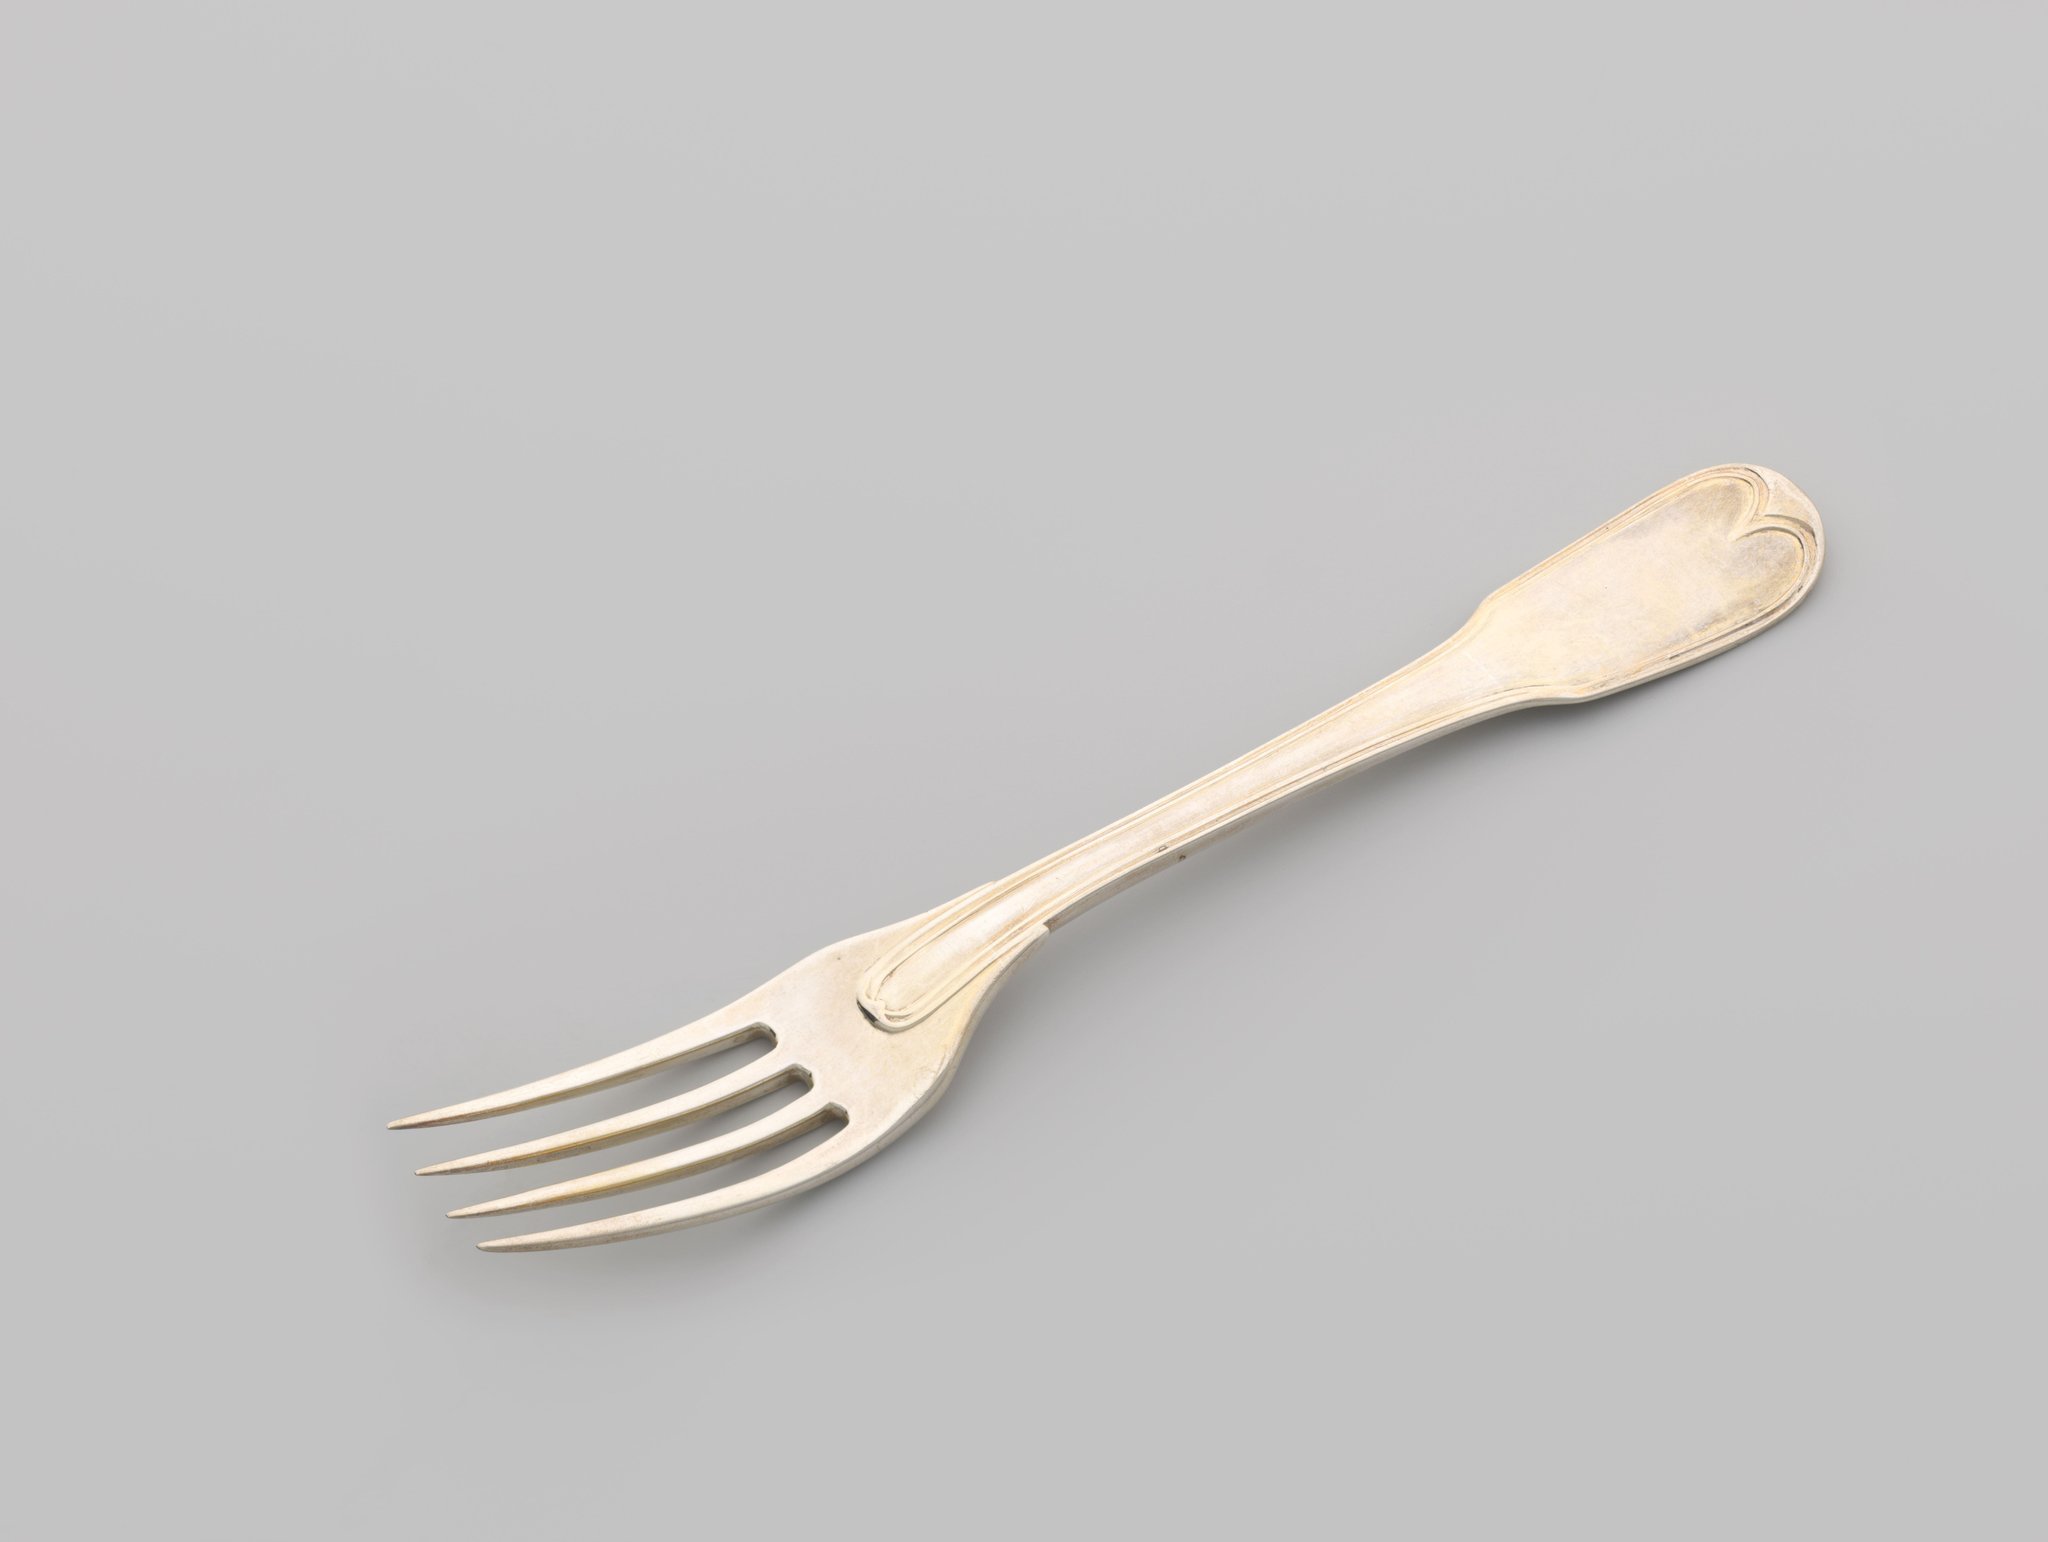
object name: fork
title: Dessertvork met het helmteken Clifford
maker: roelof helweg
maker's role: silversmith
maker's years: 1758-1843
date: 1806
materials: silver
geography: amsterdam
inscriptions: maker's mark: ‘RH in ovaal’, alloy mark: ‘Hollandse leeuw’, date letter: ‘X (=1806)’, town mark: ‘Amsterdam’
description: De viertandige vork is aan zowel boven- als onderzijde door middel van enkel lof verbonden met de platte, gebogen steel, die zich verbreedt naar het spatelvormige uiteinde. Boven- en onderzijde van de steel worden omgeven door een dubbele filetrand, die bij het uiteinde ingezwenkt is. Op de onderzijde van de spatel is het helmteken Clifford gegraveerd.